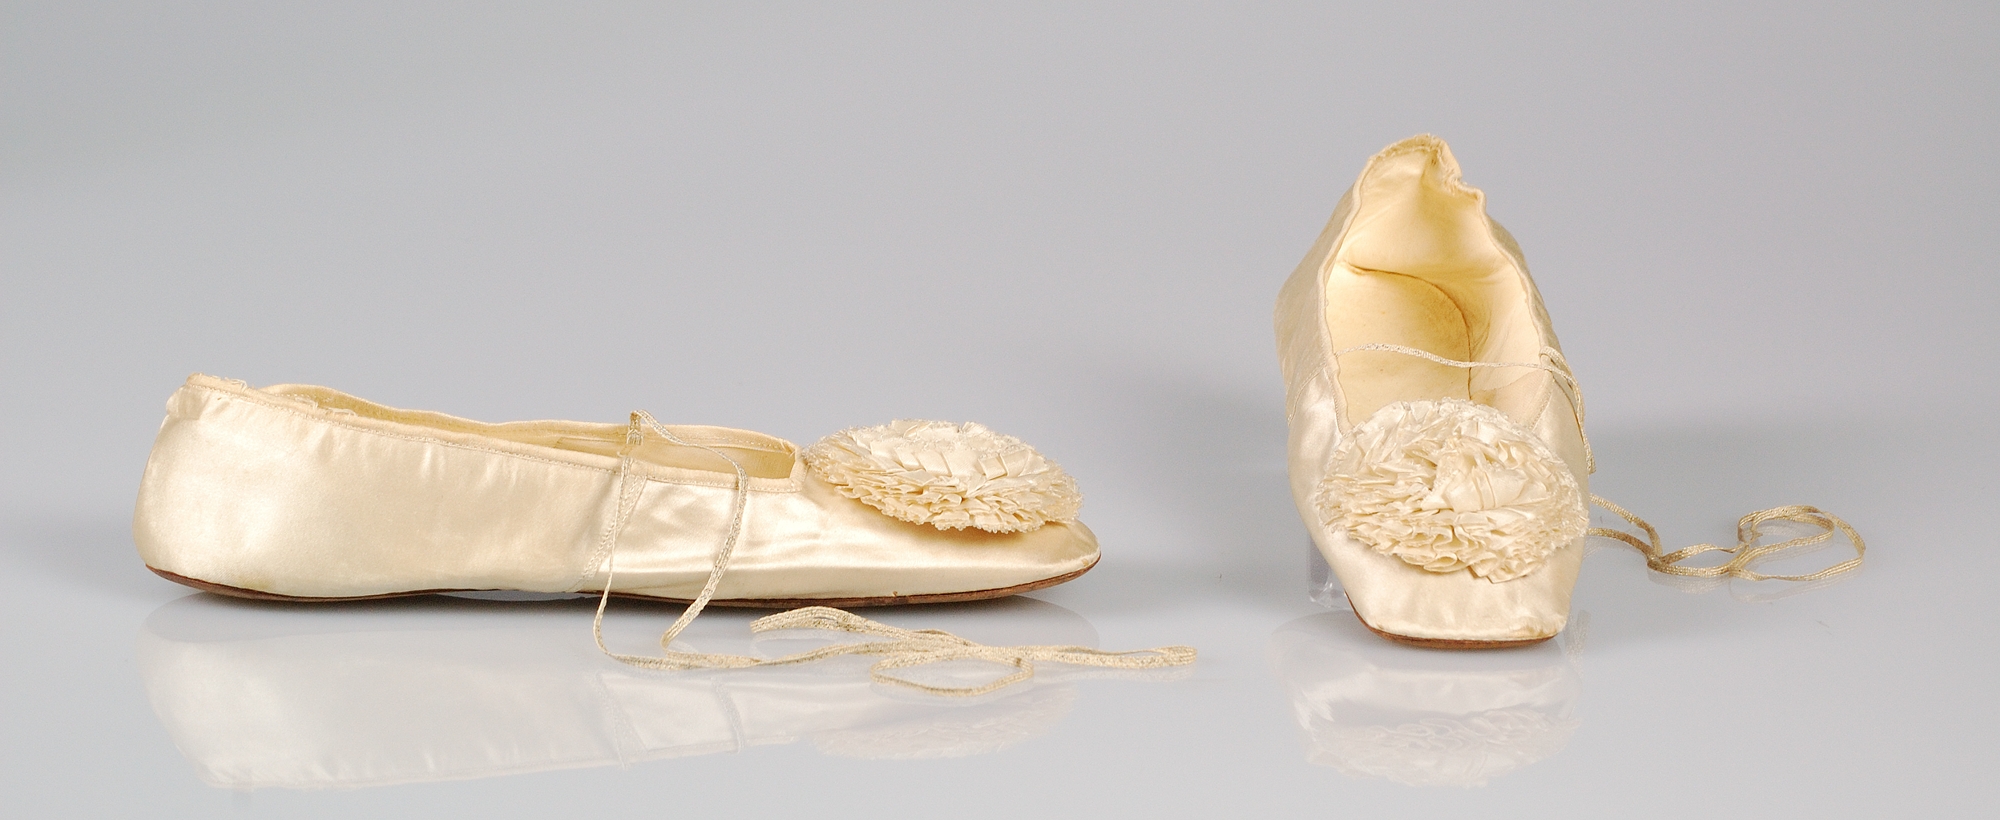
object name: wedding slipper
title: Wedding slippers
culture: french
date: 1865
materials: silk